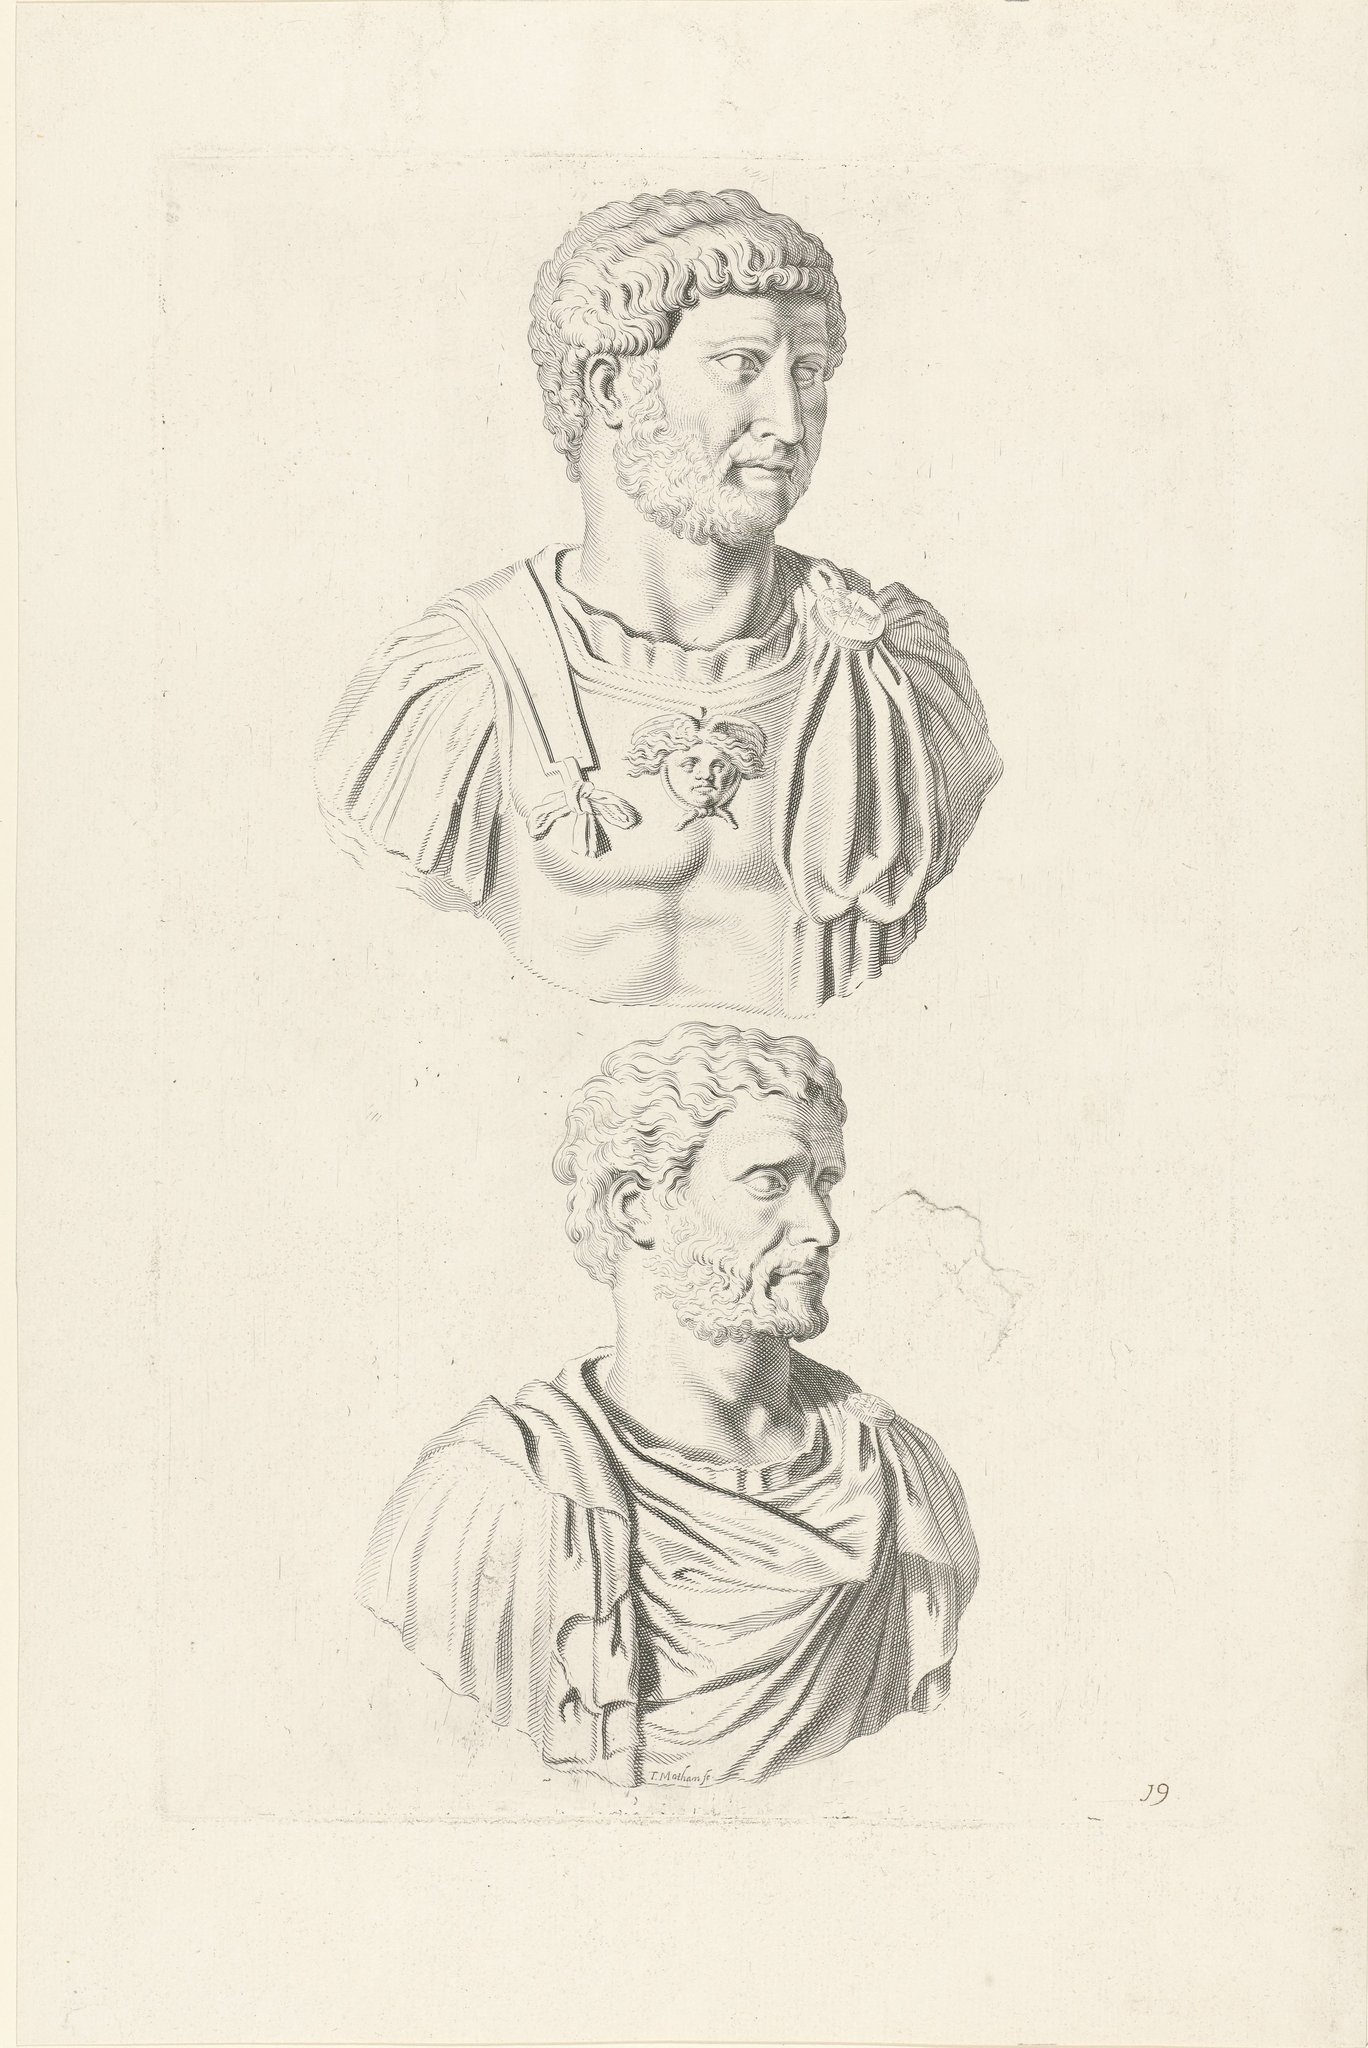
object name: print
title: Bustes van Hadrianus en Antoninus Pius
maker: theodor matham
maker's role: draughtsman, print maker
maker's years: 1605-1676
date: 1640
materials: paper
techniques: engraving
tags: rome, vincenzo giustiniani (1564-1637), piece of sculpture, reproduction of a piece of sculpture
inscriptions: number: ‘19’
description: Twee bustes van Romeinen. Boven de buste van keizer Hadrianus en onder van keizer Antoninus Pius. Prent uit een publicatie met reproductieprenten naar de sculpturen in de verzameling in de Galleria Giustiniani te Rome.